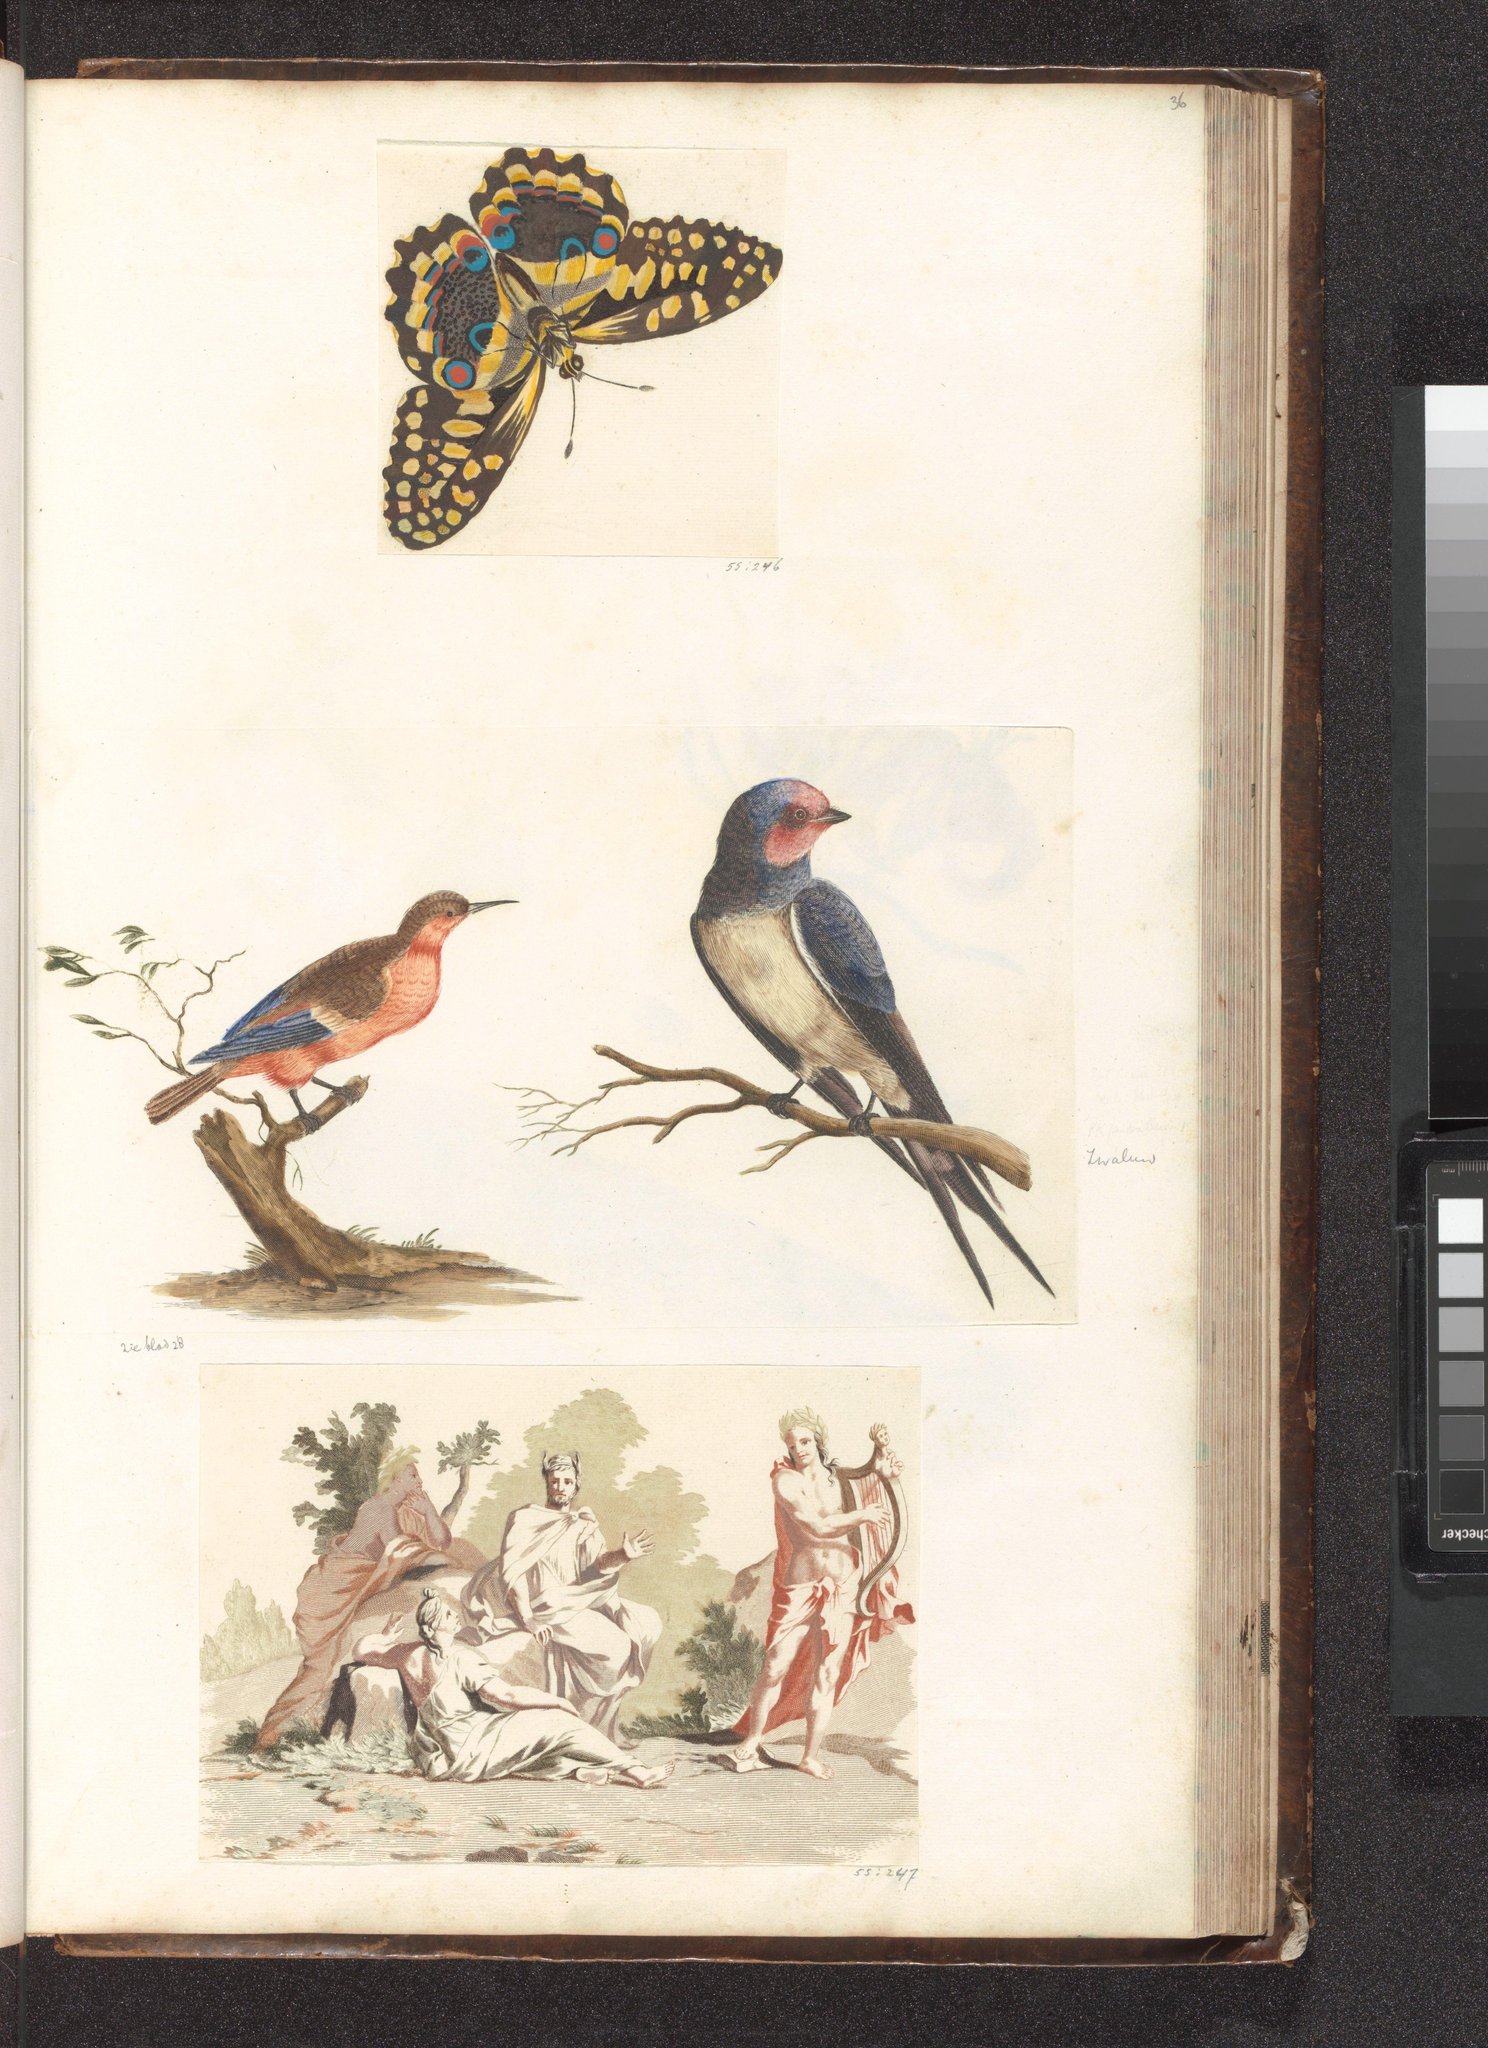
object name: print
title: Bijeneter op een boomstronk en zwaluw op een tak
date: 1688-1698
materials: paper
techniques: printing, engraving, lithography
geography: netherlands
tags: birds, song-birds: swallow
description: Deze prent maakt deel uit van een album.